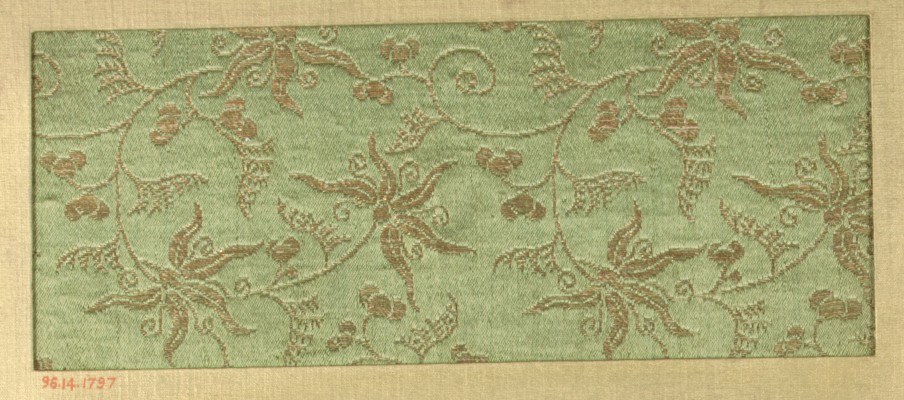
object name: piece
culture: japanese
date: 1701-1900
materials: silk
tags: flowers